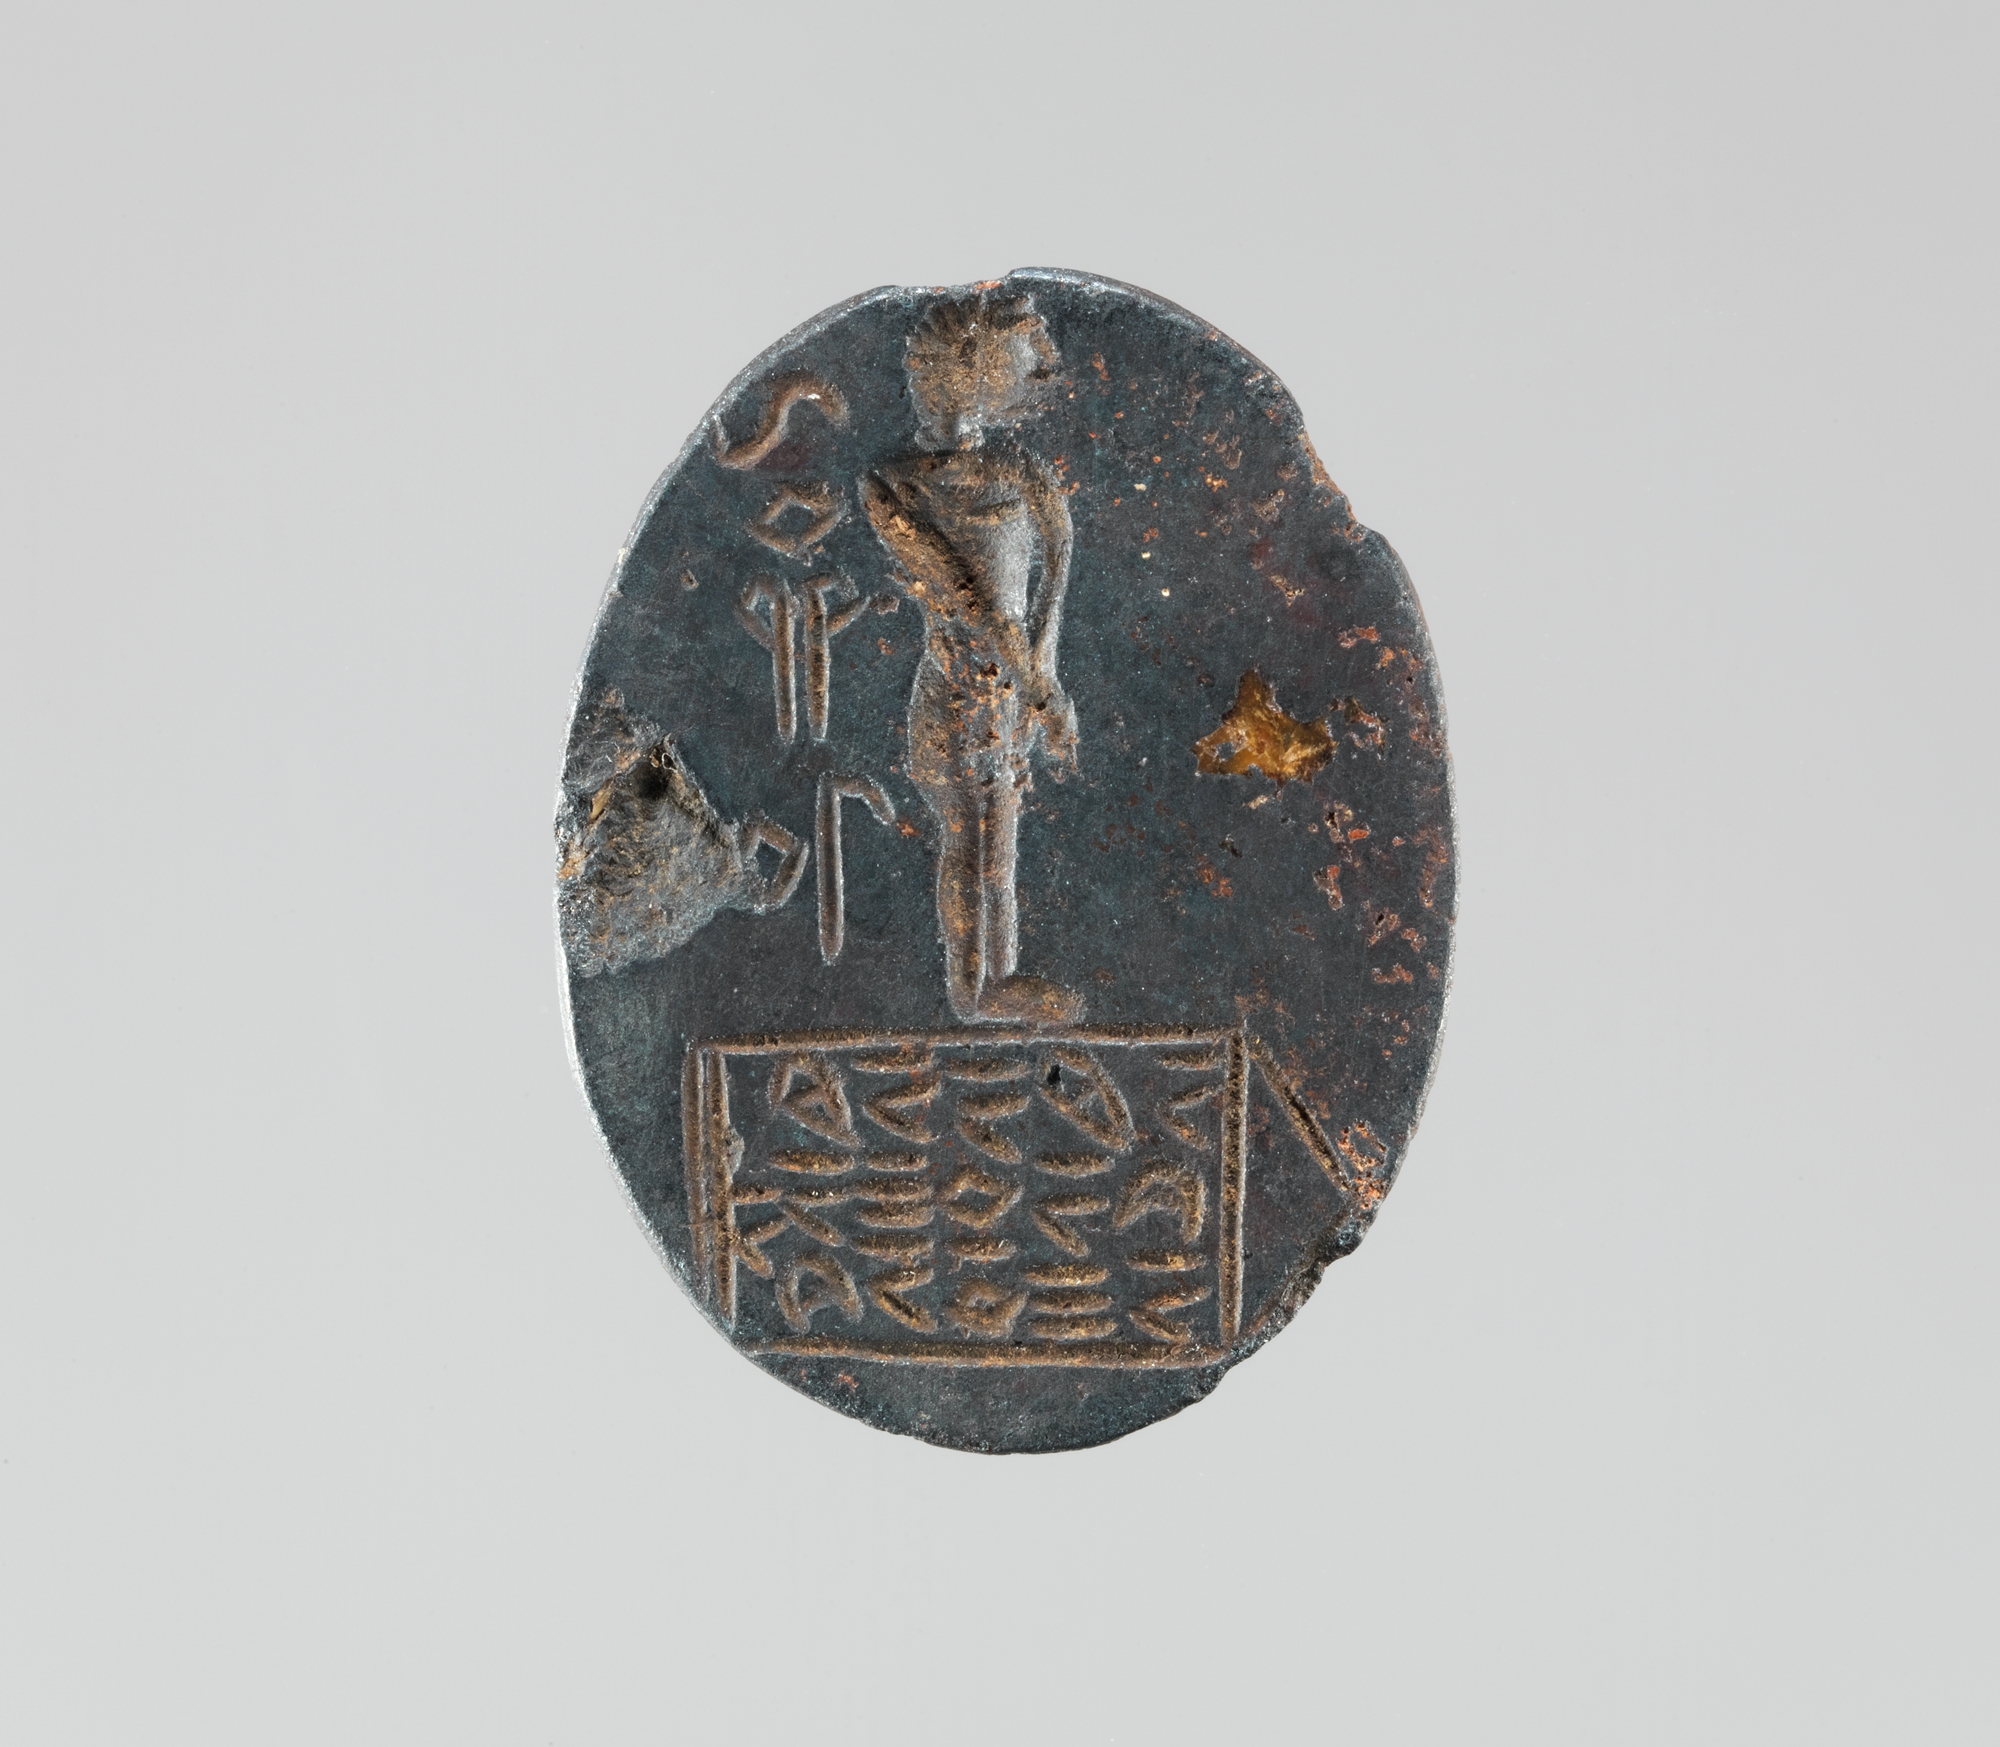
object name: intaglio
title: Haematite intaglio: Youth on inscribed stele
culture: roman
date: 101-200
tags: male nudes